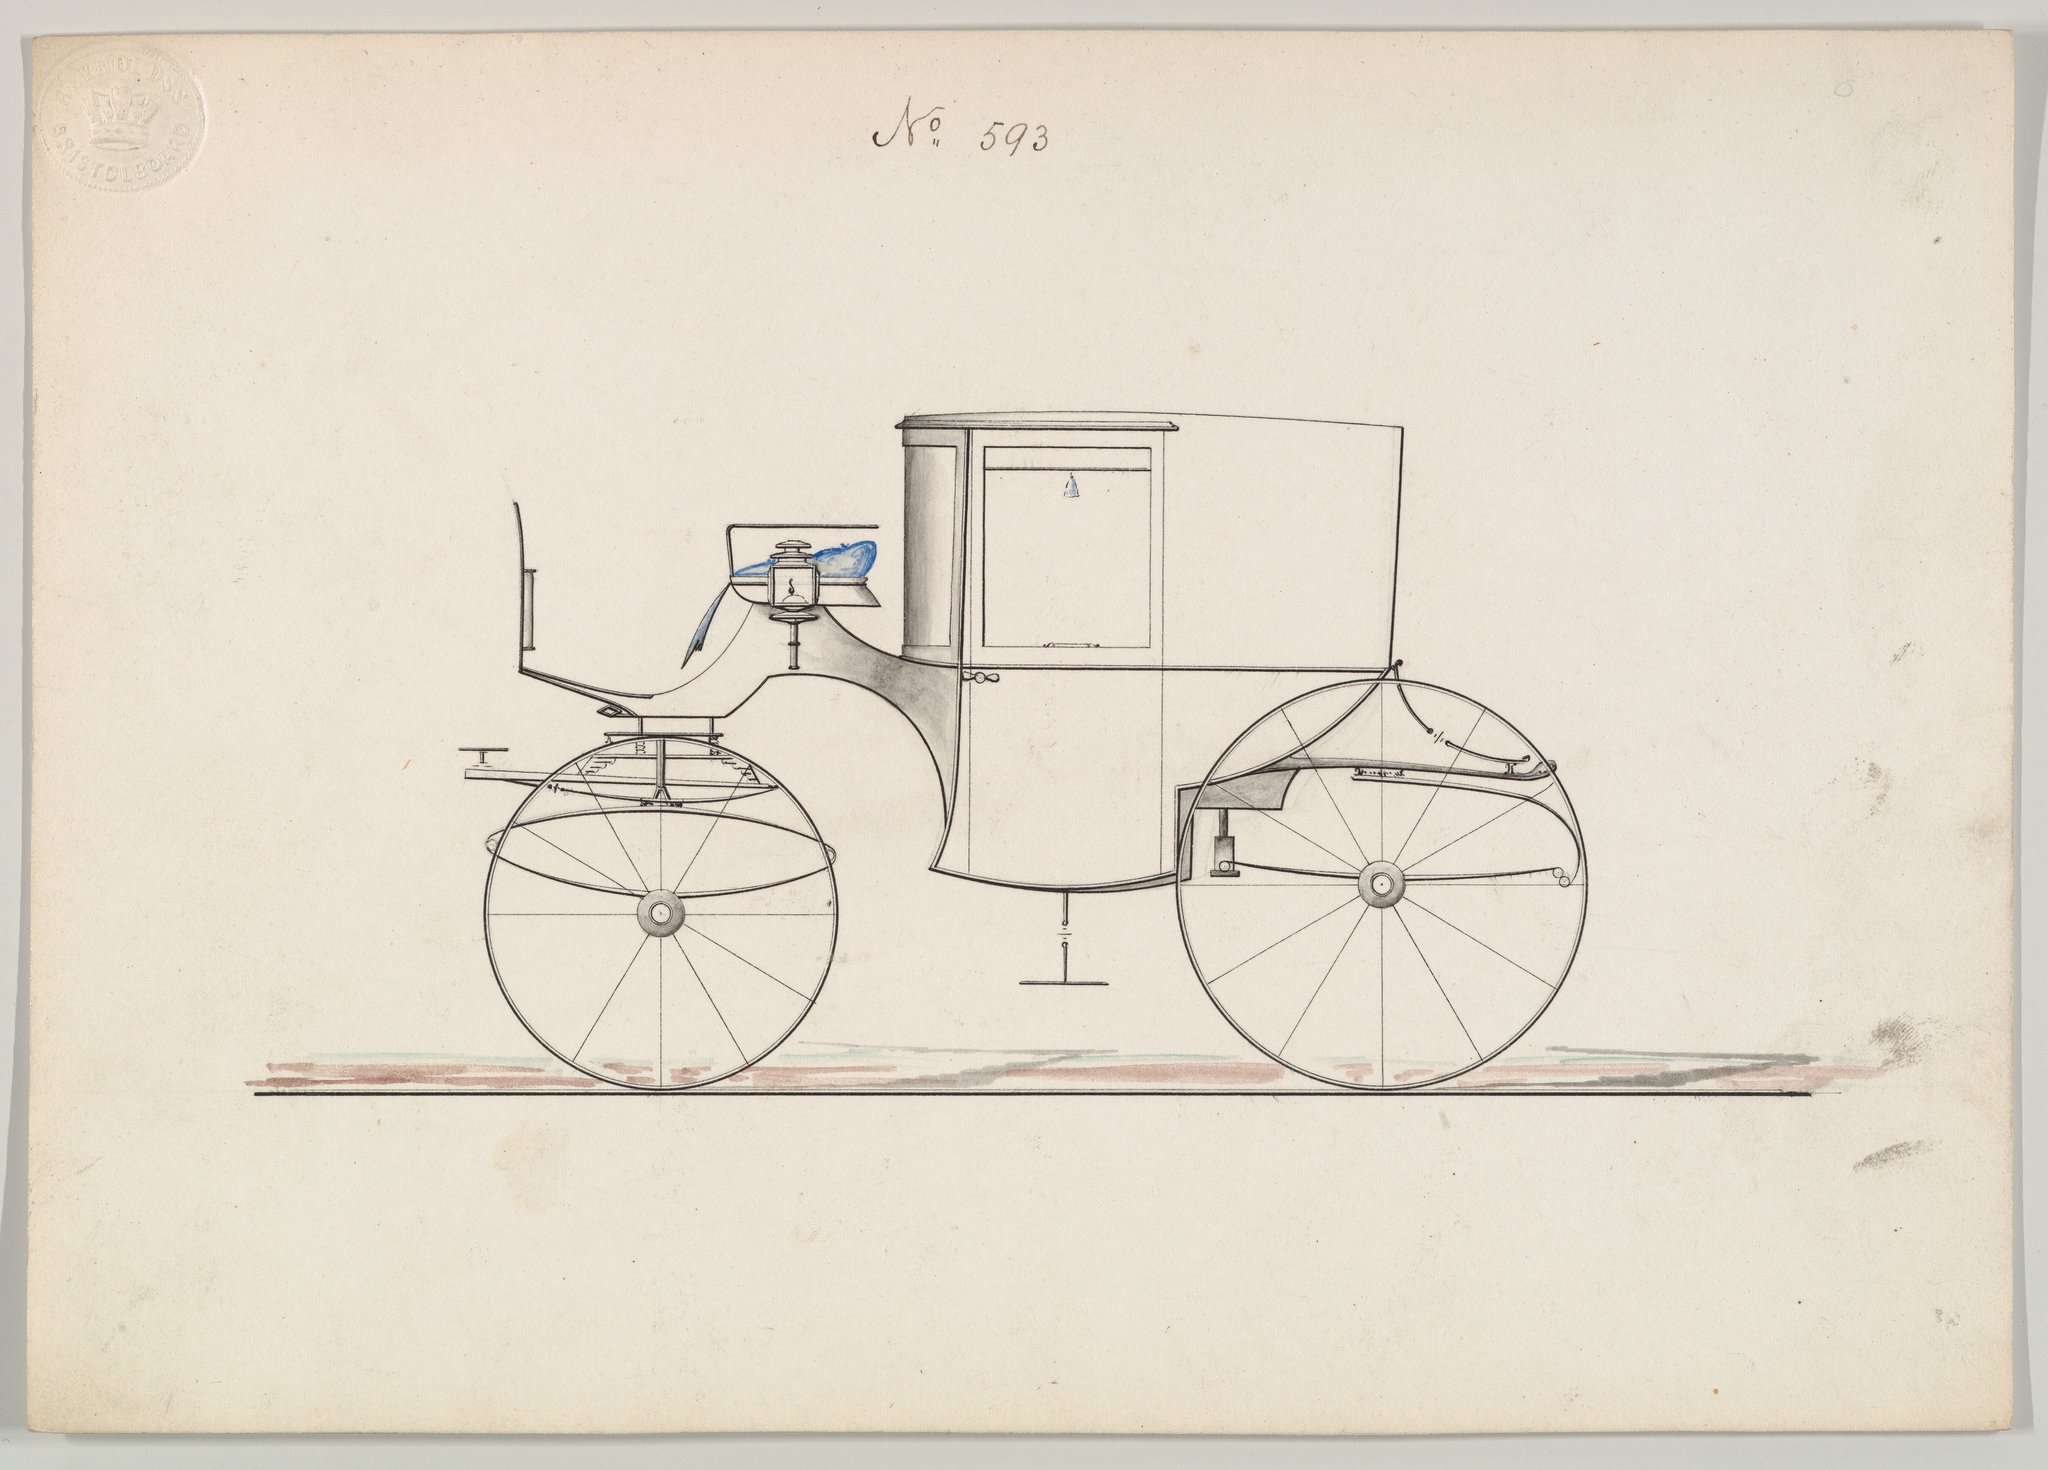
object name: drawing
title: Coupé #593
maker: brewster & co.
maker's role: manufacturer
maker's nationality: american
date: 1850-1870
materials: ink, watercolor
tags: carriages